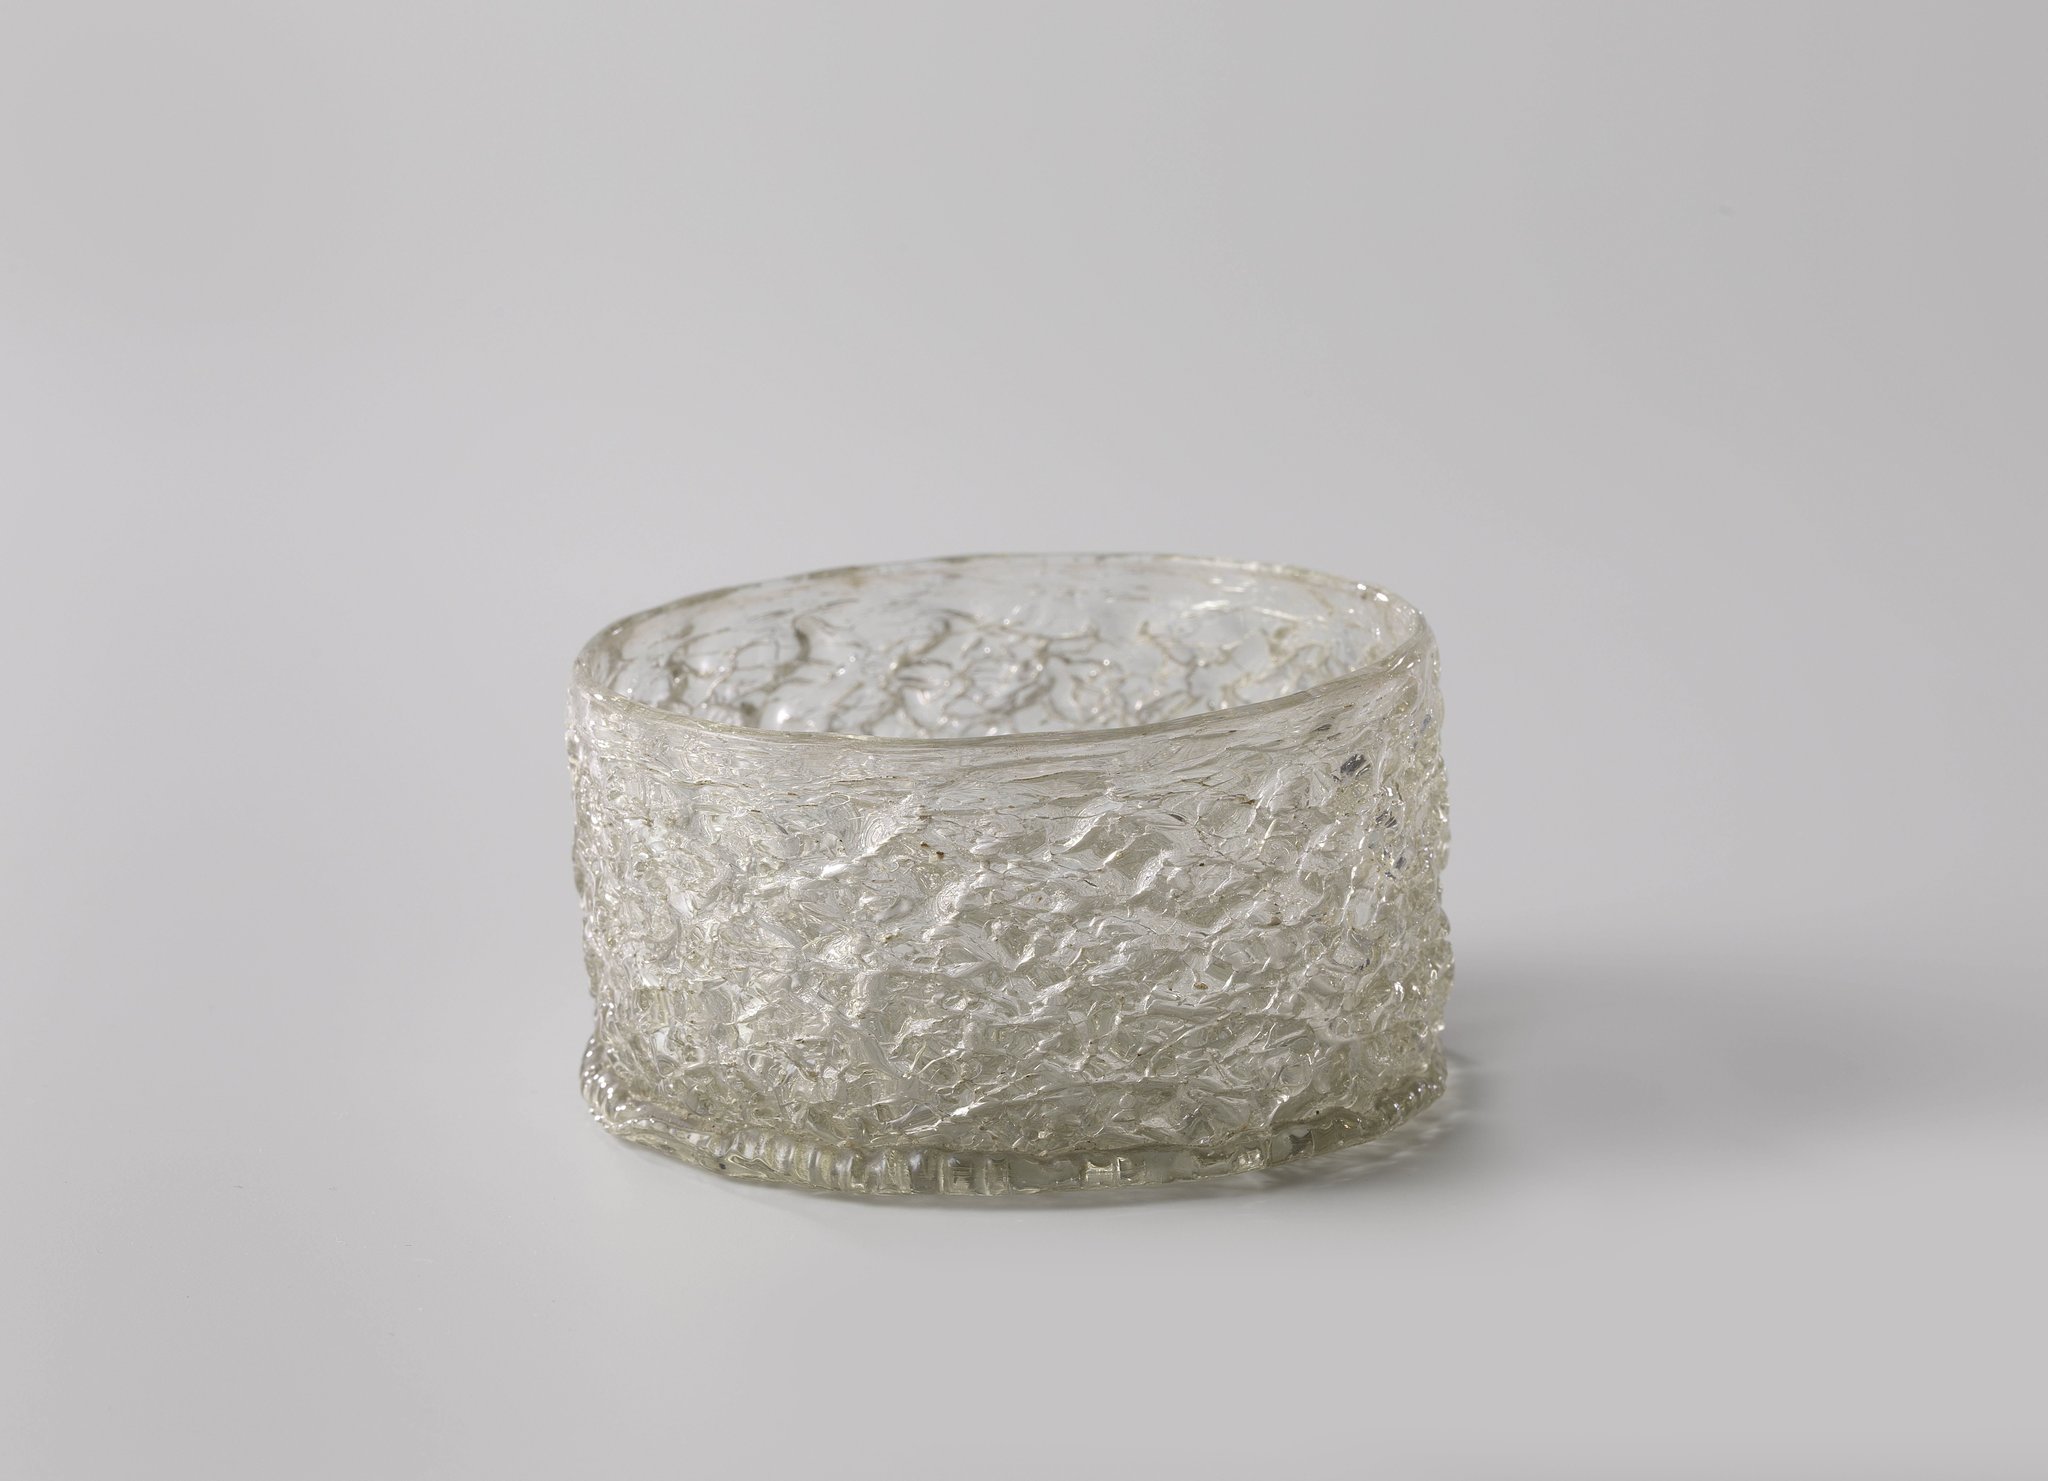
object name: cup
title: Beker van ijsglas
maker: Anonymous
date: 1550-1650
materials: glass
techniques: façon de venise, glassblowing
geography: low countries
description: Kleine beker van ijsglas, met ingestoken bodem. Geribde standring van helder glas. Cilindervormig lichaam.